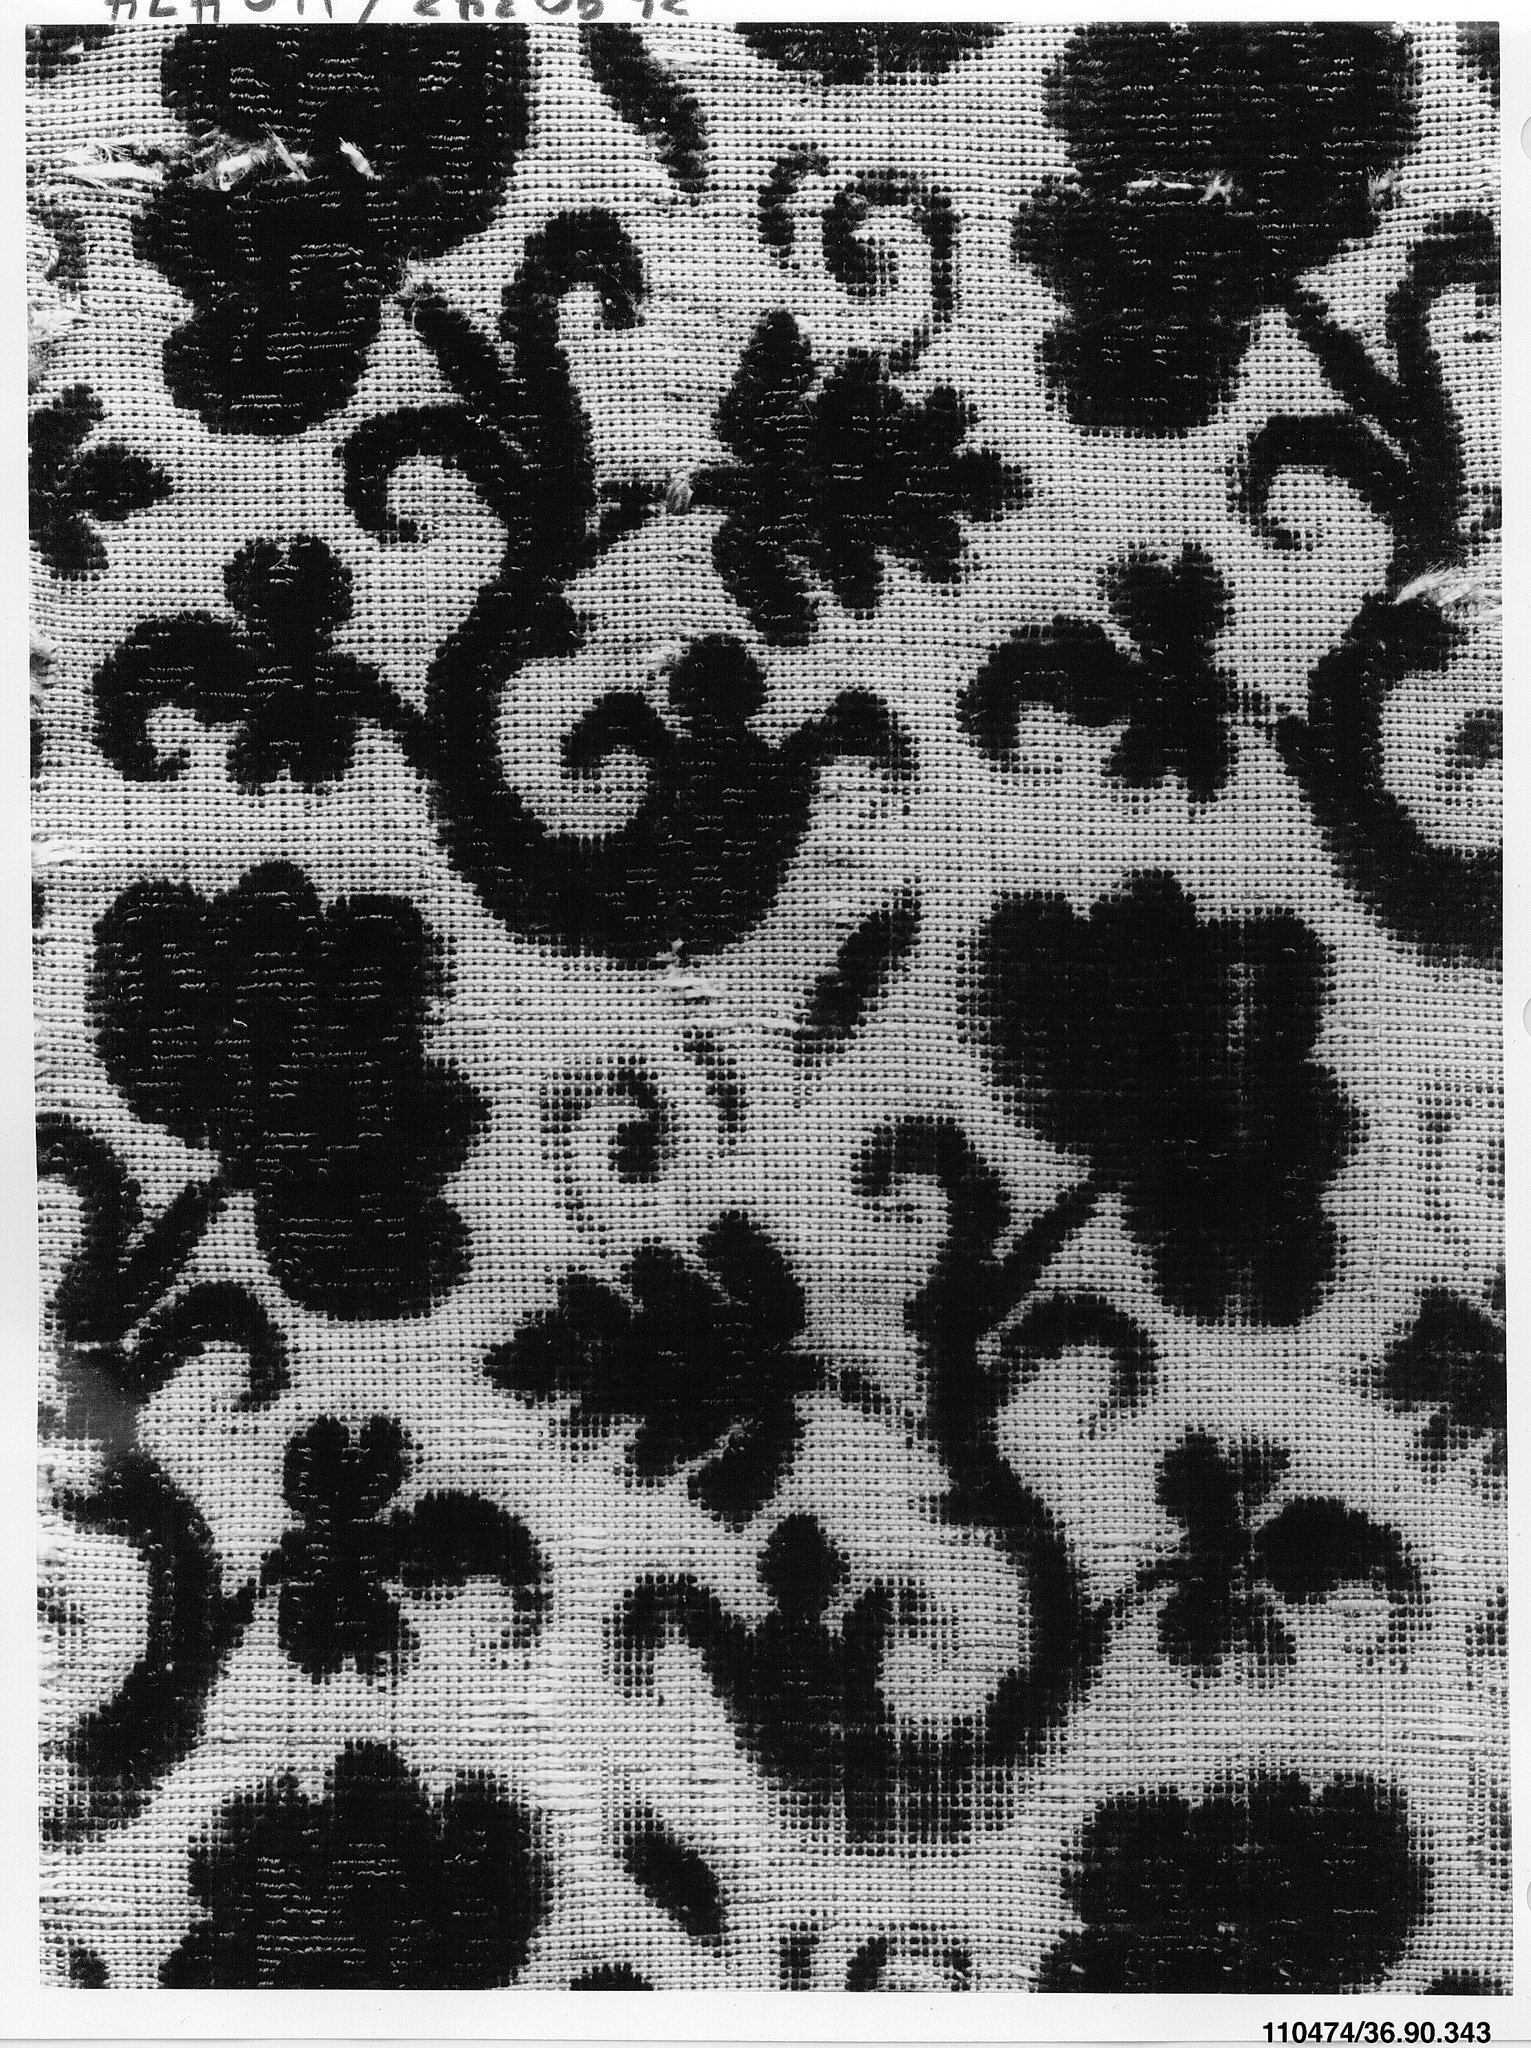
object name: piece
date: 1501-1700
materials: silk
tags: flowers